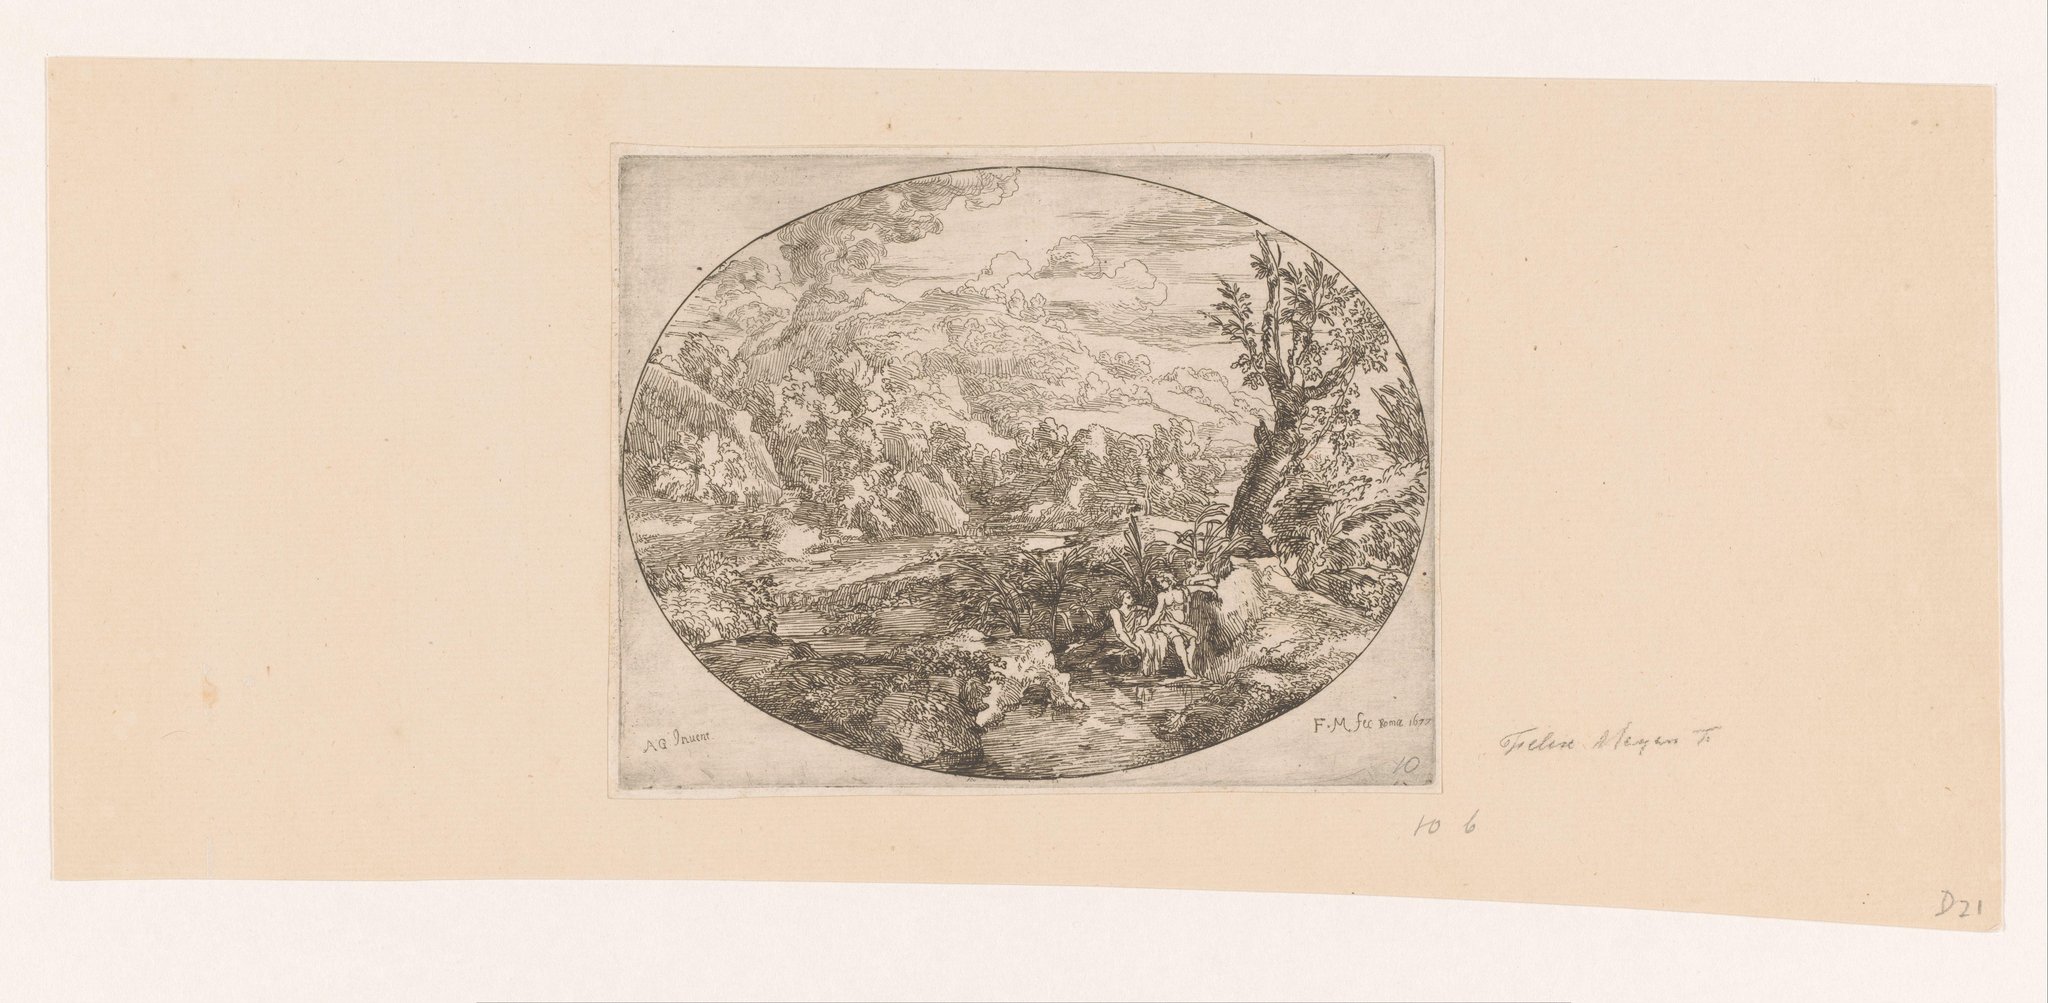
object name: print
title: Landschap met rivier en baders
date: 1677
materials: paper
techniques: etching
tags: swimming (movement in water) - aa - female human figure, landscapes with waters, waterscapes, seascapes (in the temperate zone) (+ landscape with figures, staffage)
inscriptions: collector's mark: Lugt 240, collector's mark: Lugt 1838